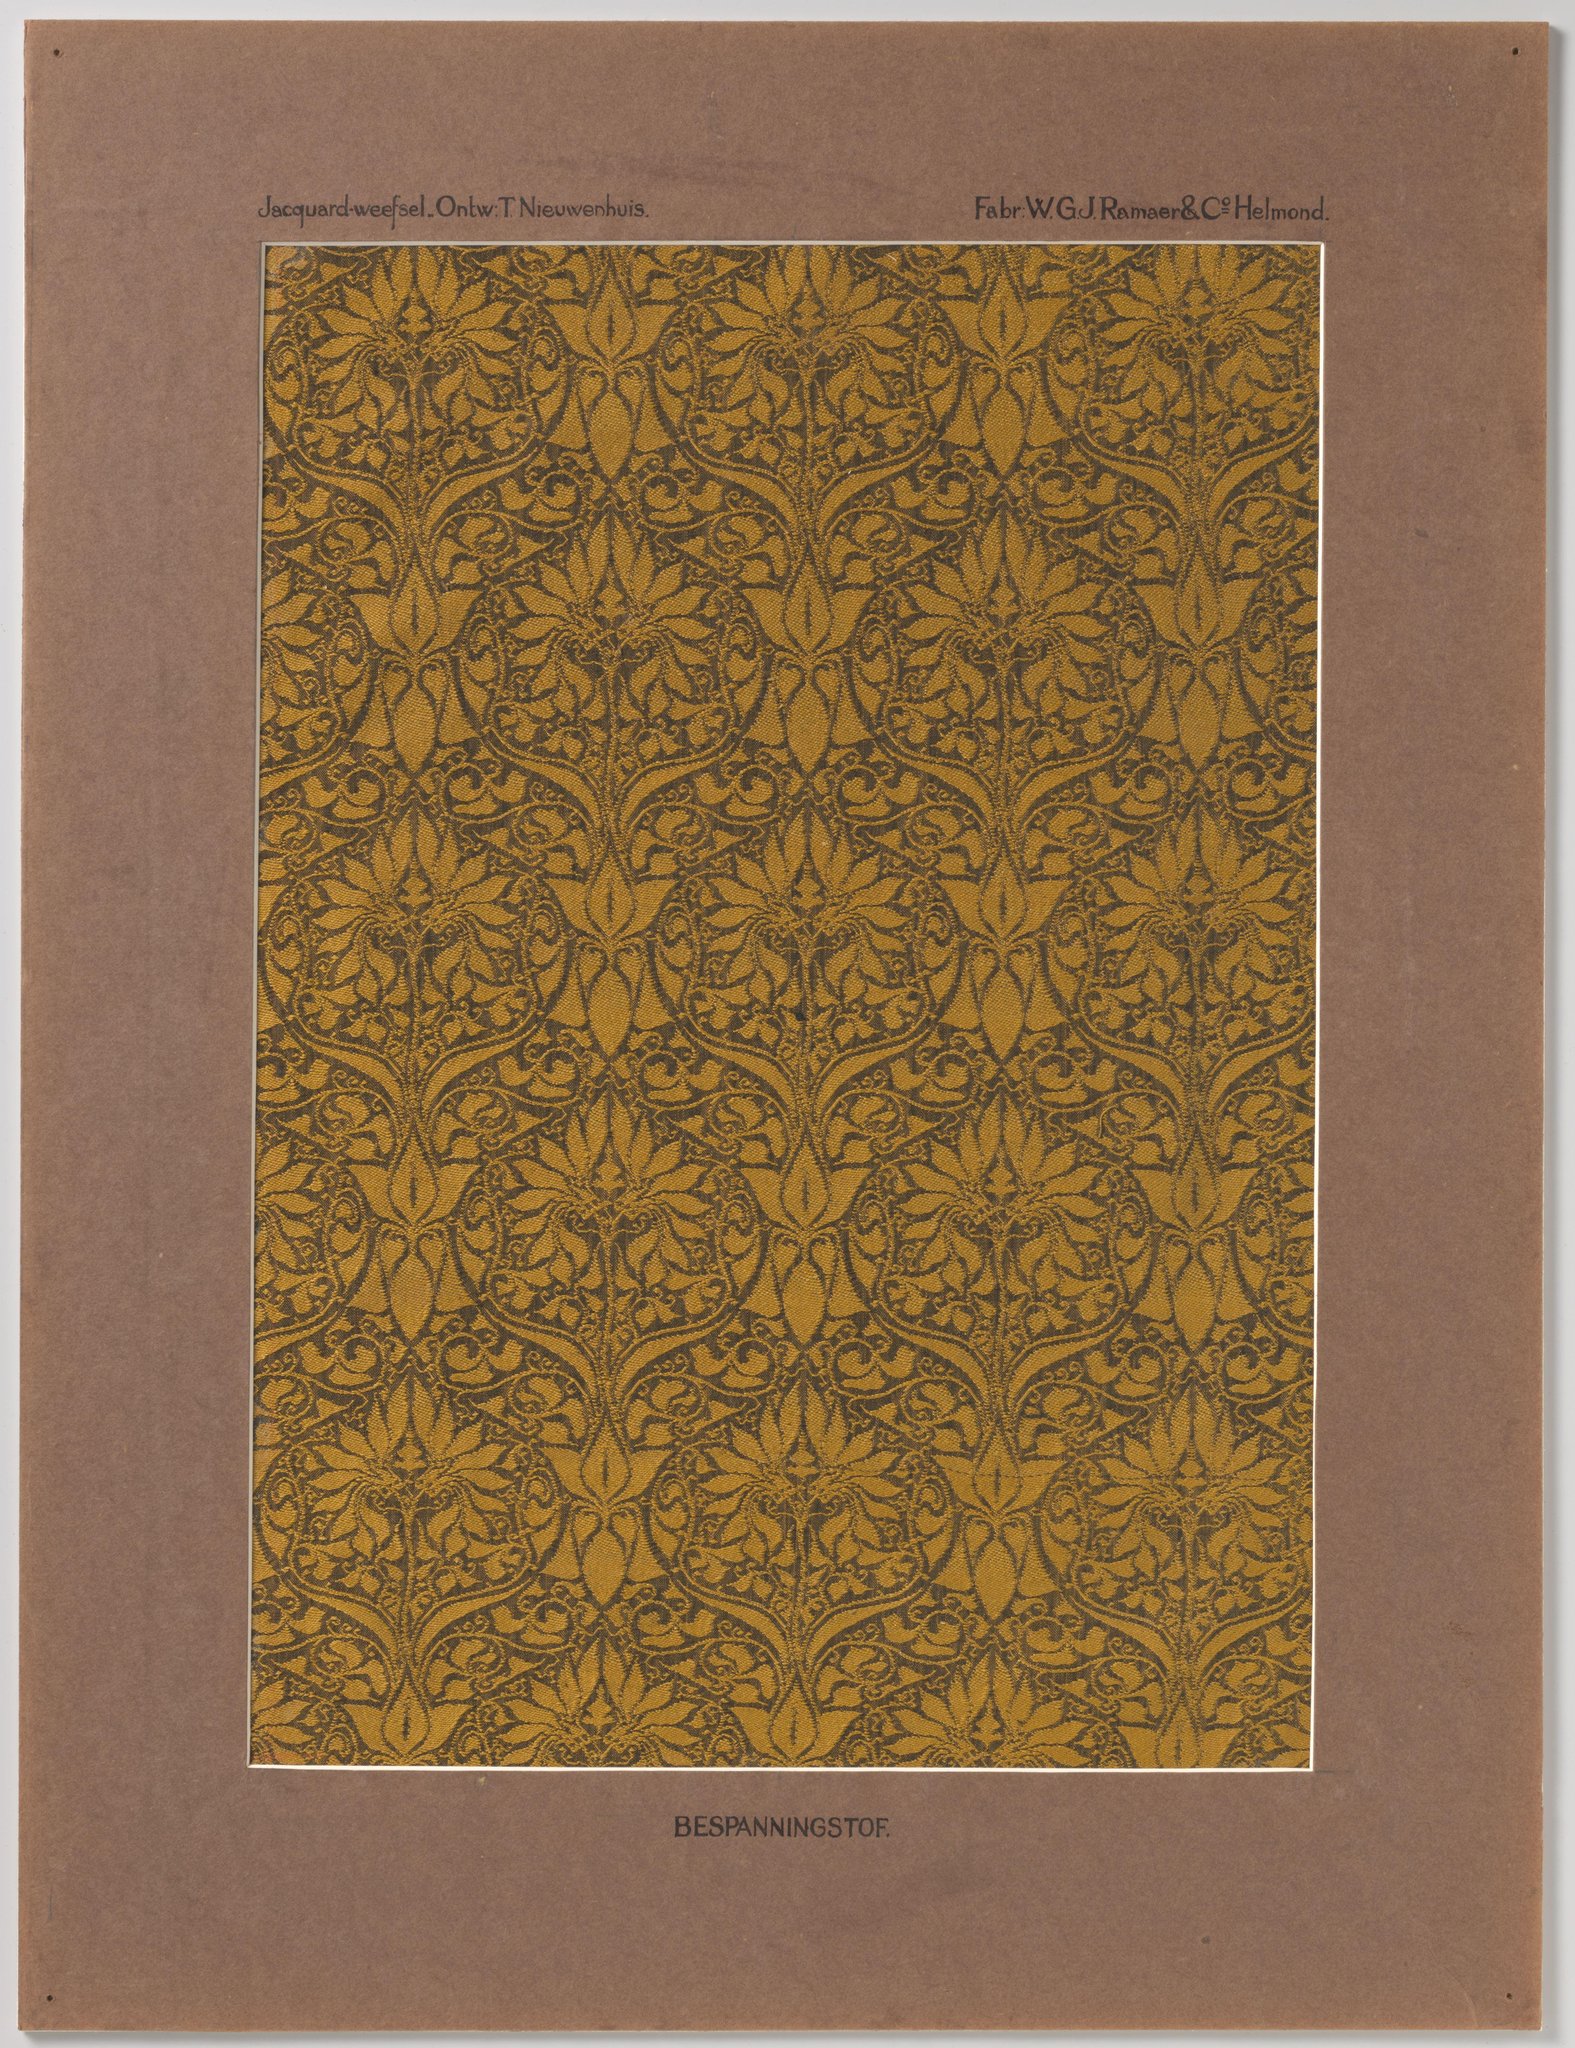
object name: sample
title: Staal bespanningsstof naar ontwerp van Theo Nieuwenhuis in passe-partout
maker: theo nieuwenhuis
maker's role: designer, draughtsman, print maker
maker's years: 1866-1951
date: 1910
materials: cardboard, cotton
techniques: jacquard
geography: netherlands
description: Staal bespanningsstof van jacquardgeweven katoen naar ontwerp van Theo Nieuwenhuis, in origineel passe-partout. Het patroon bestaal uit spitsovaalvormige medaillons waarin gestileerde bloem- en bladmotieven, omgeven door een band met gestileerde bladranken en bloemen.